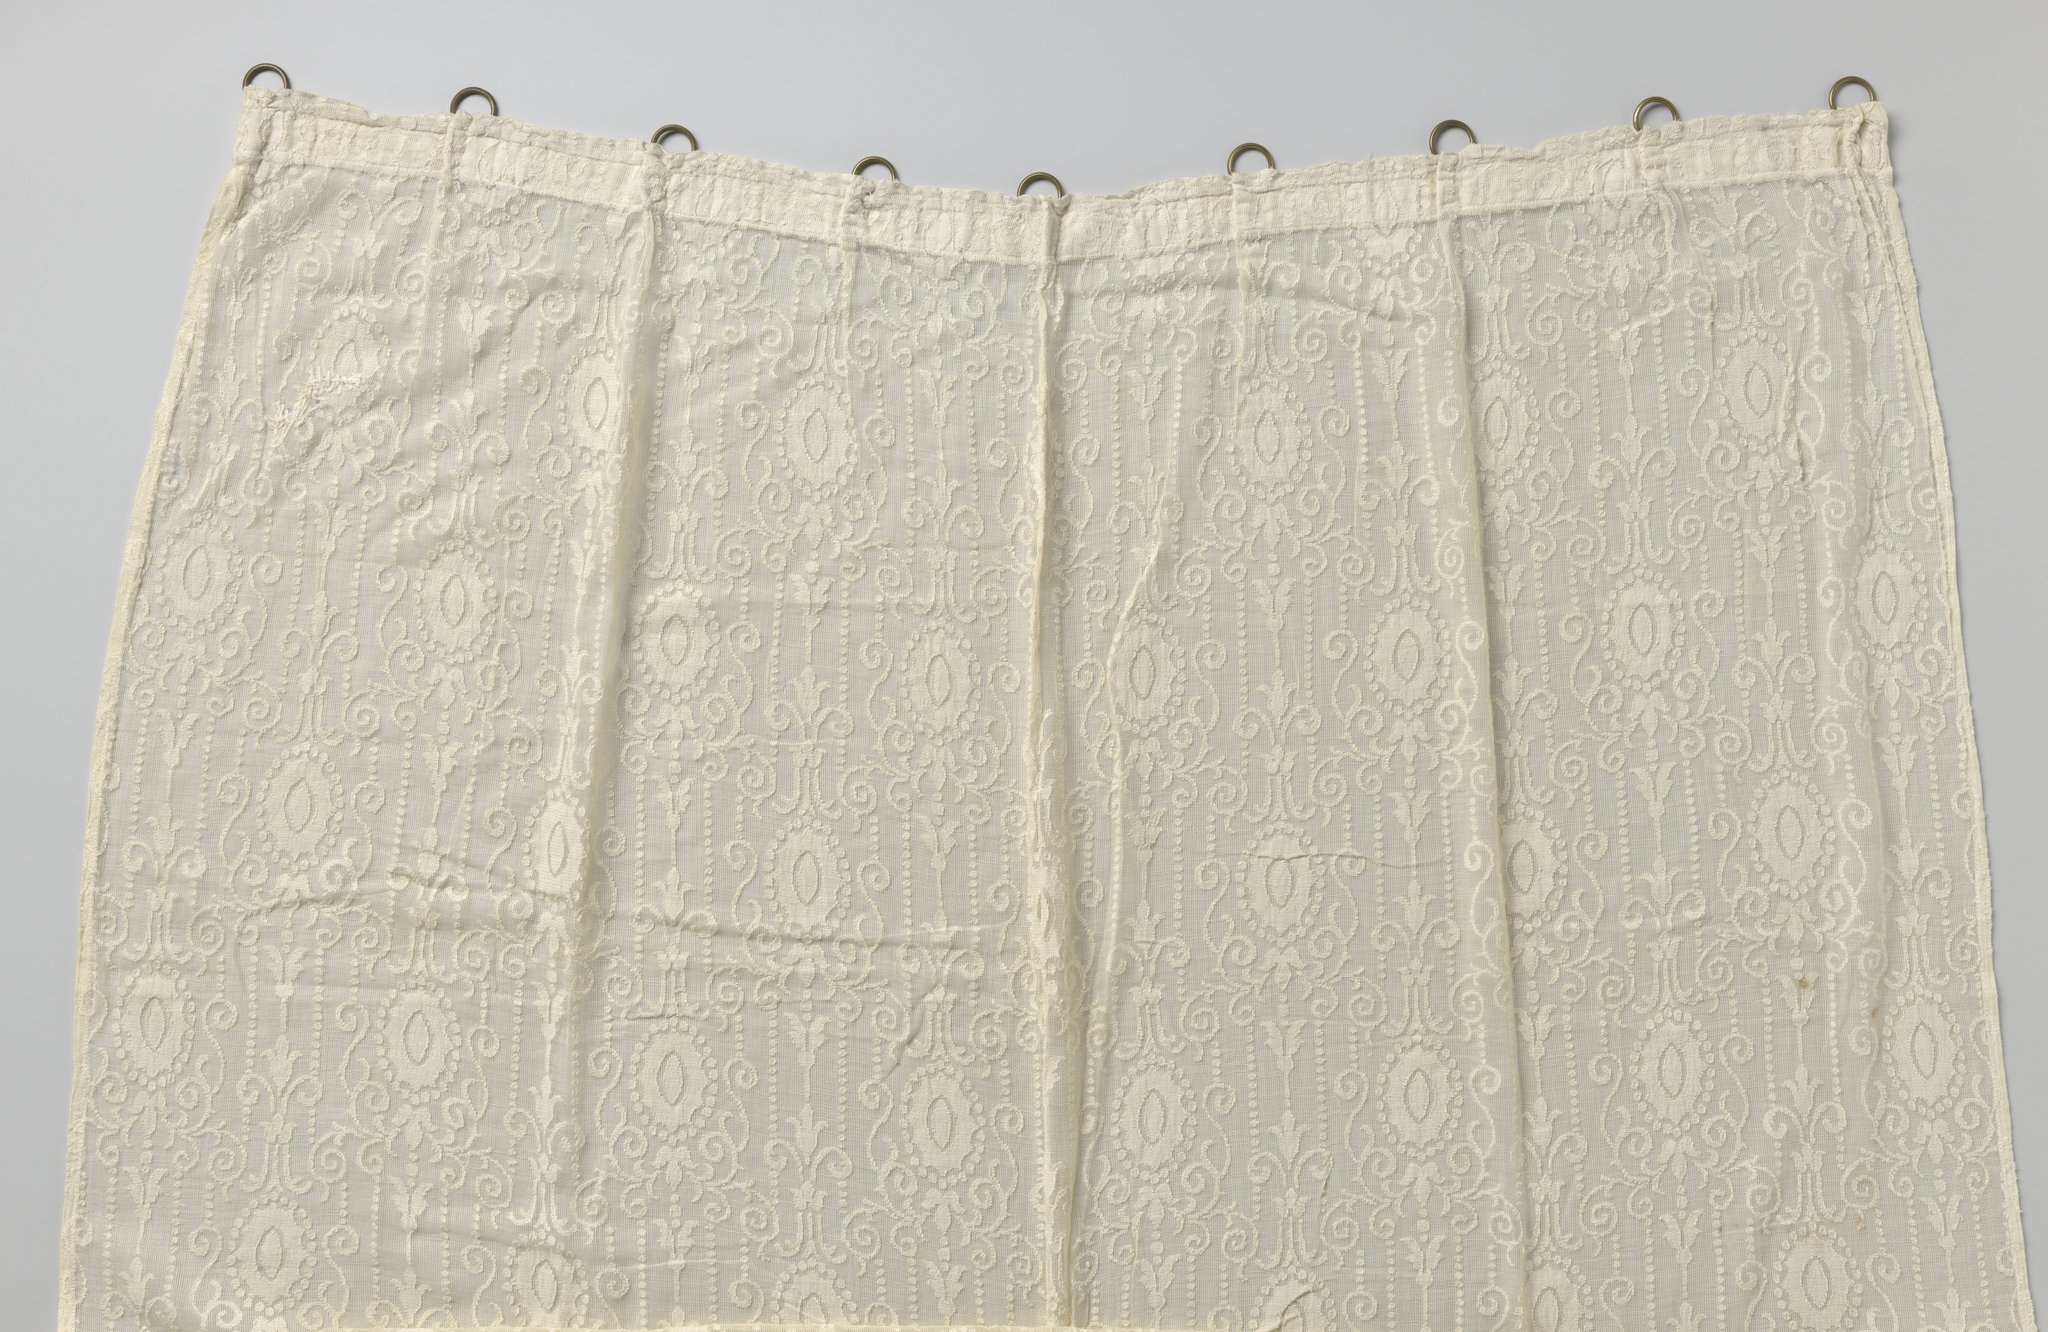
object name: curtain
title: Vitrage in neo Lodewijk-XVI stijl, met koperen ringen.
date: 1895-1905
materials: copper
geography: netherlands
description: Vitrage in neo Lodewijk-XVIe stijl, met koperen ringen.